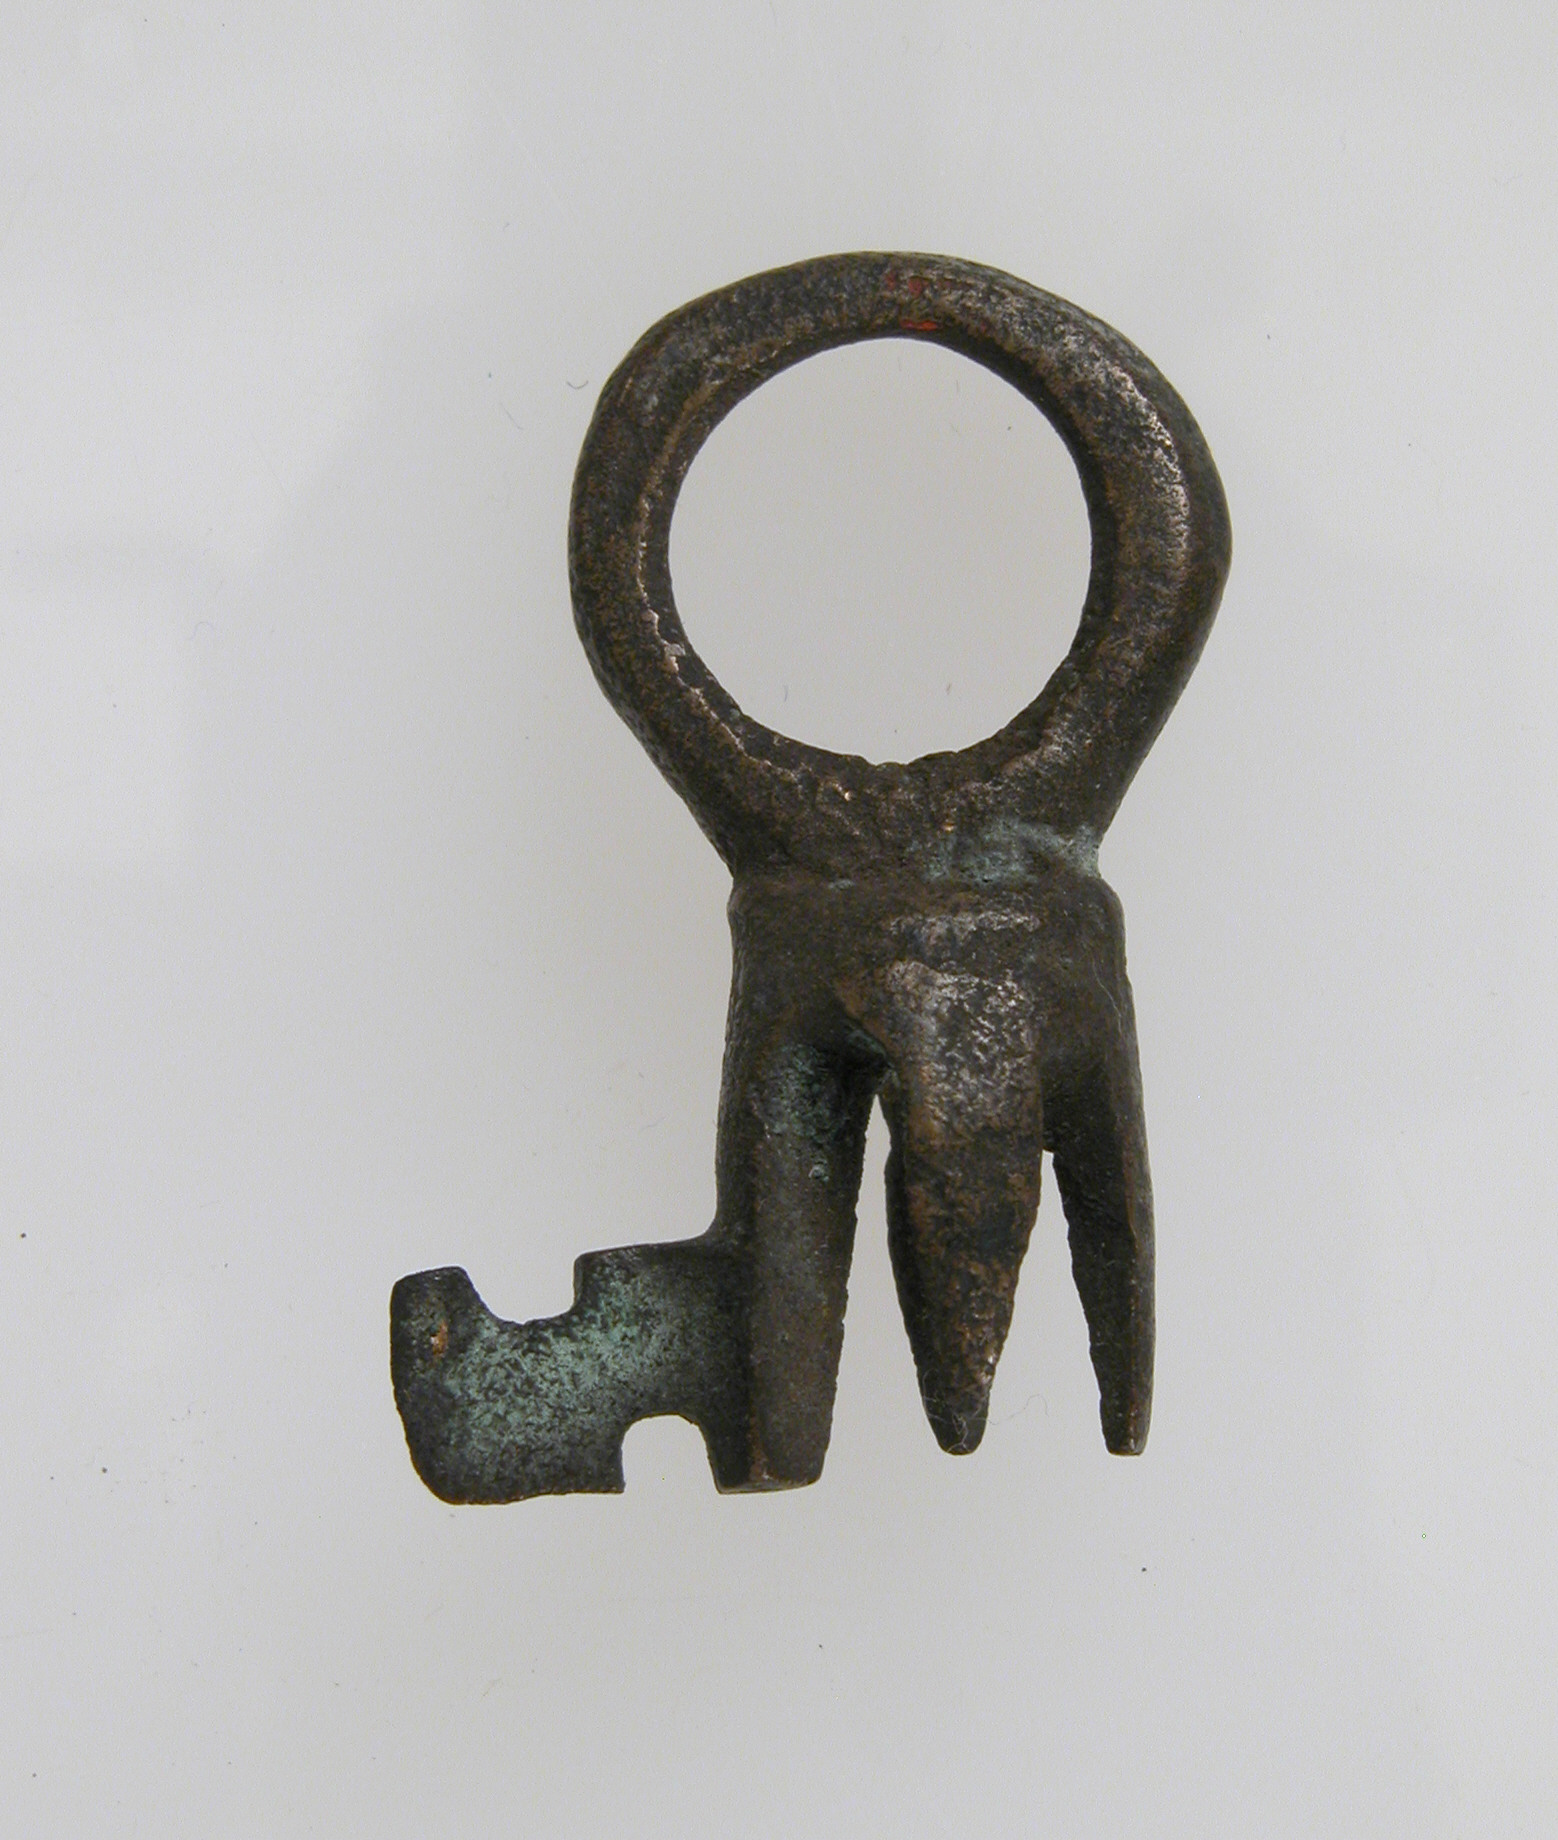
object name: key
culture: roman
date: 1-700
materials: copper alloy